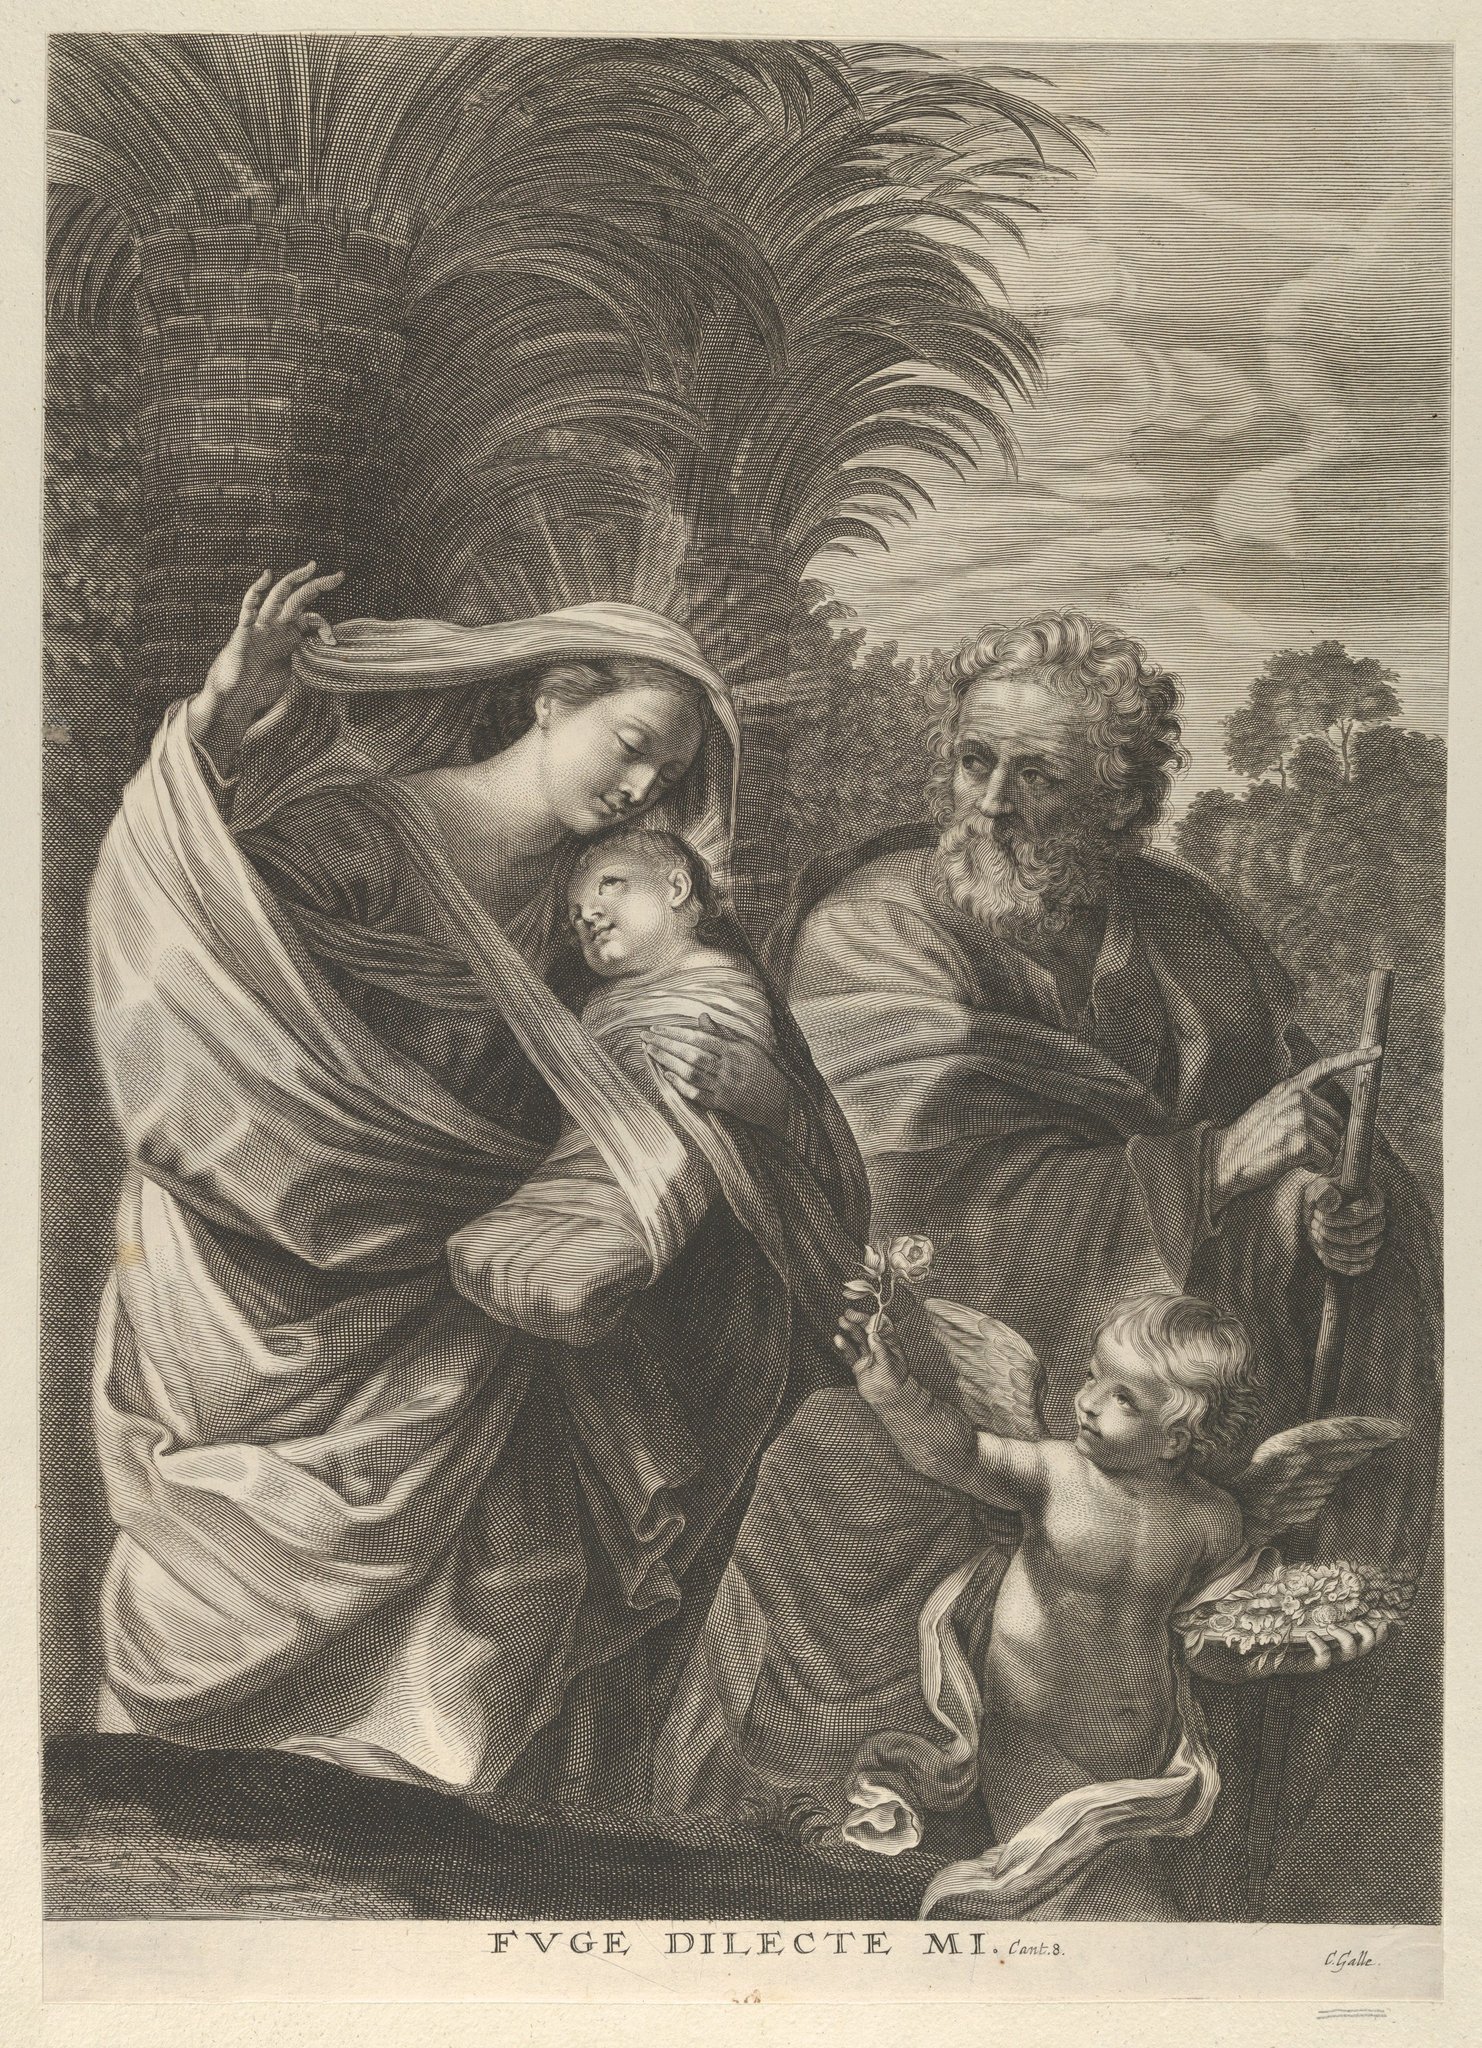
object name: print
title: The Flight into Egypt; the Holy Family walking together, Saint Joseph pointing to the right and the Virgin carrying the infant Christ, an angel in front of her offering a flower, after Reni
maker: Anonymous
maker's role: artist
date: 1640-1678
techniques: engraving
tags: angels,christ,holy family,saint joseph,virgin mary